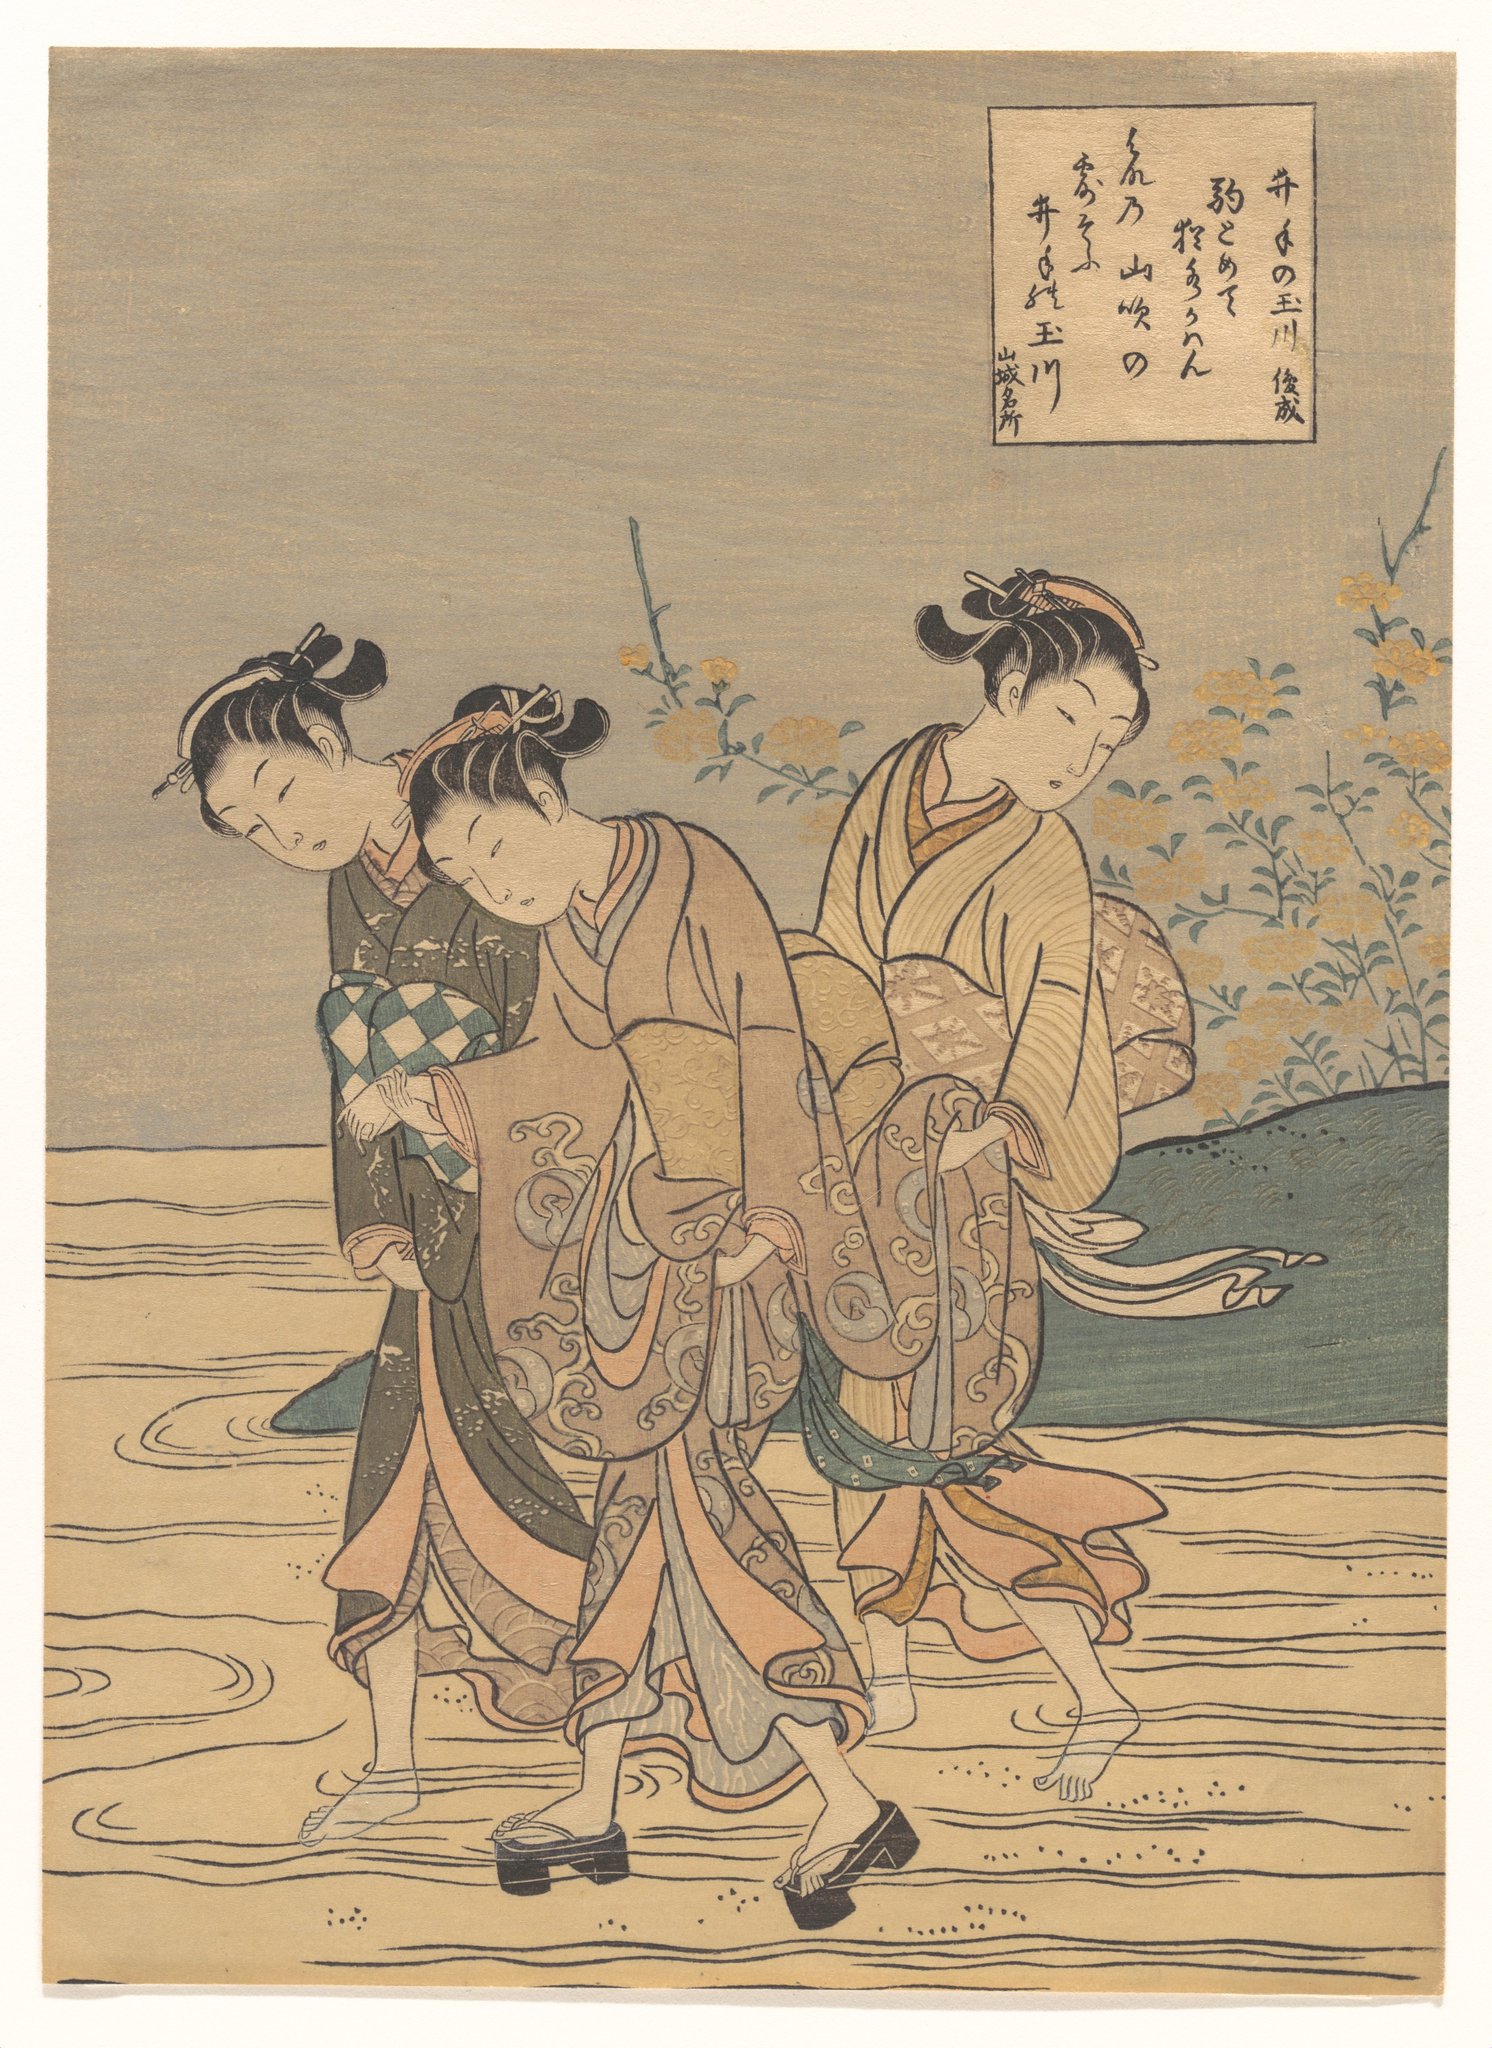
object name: print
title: The Tama River at Ide, Yamashiro Province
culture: japanese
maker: suzuki harunobu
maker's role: artist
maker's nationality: japanese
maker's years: 1725-1770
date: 1766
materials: ink, paper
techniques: woodblock print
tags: women,servants